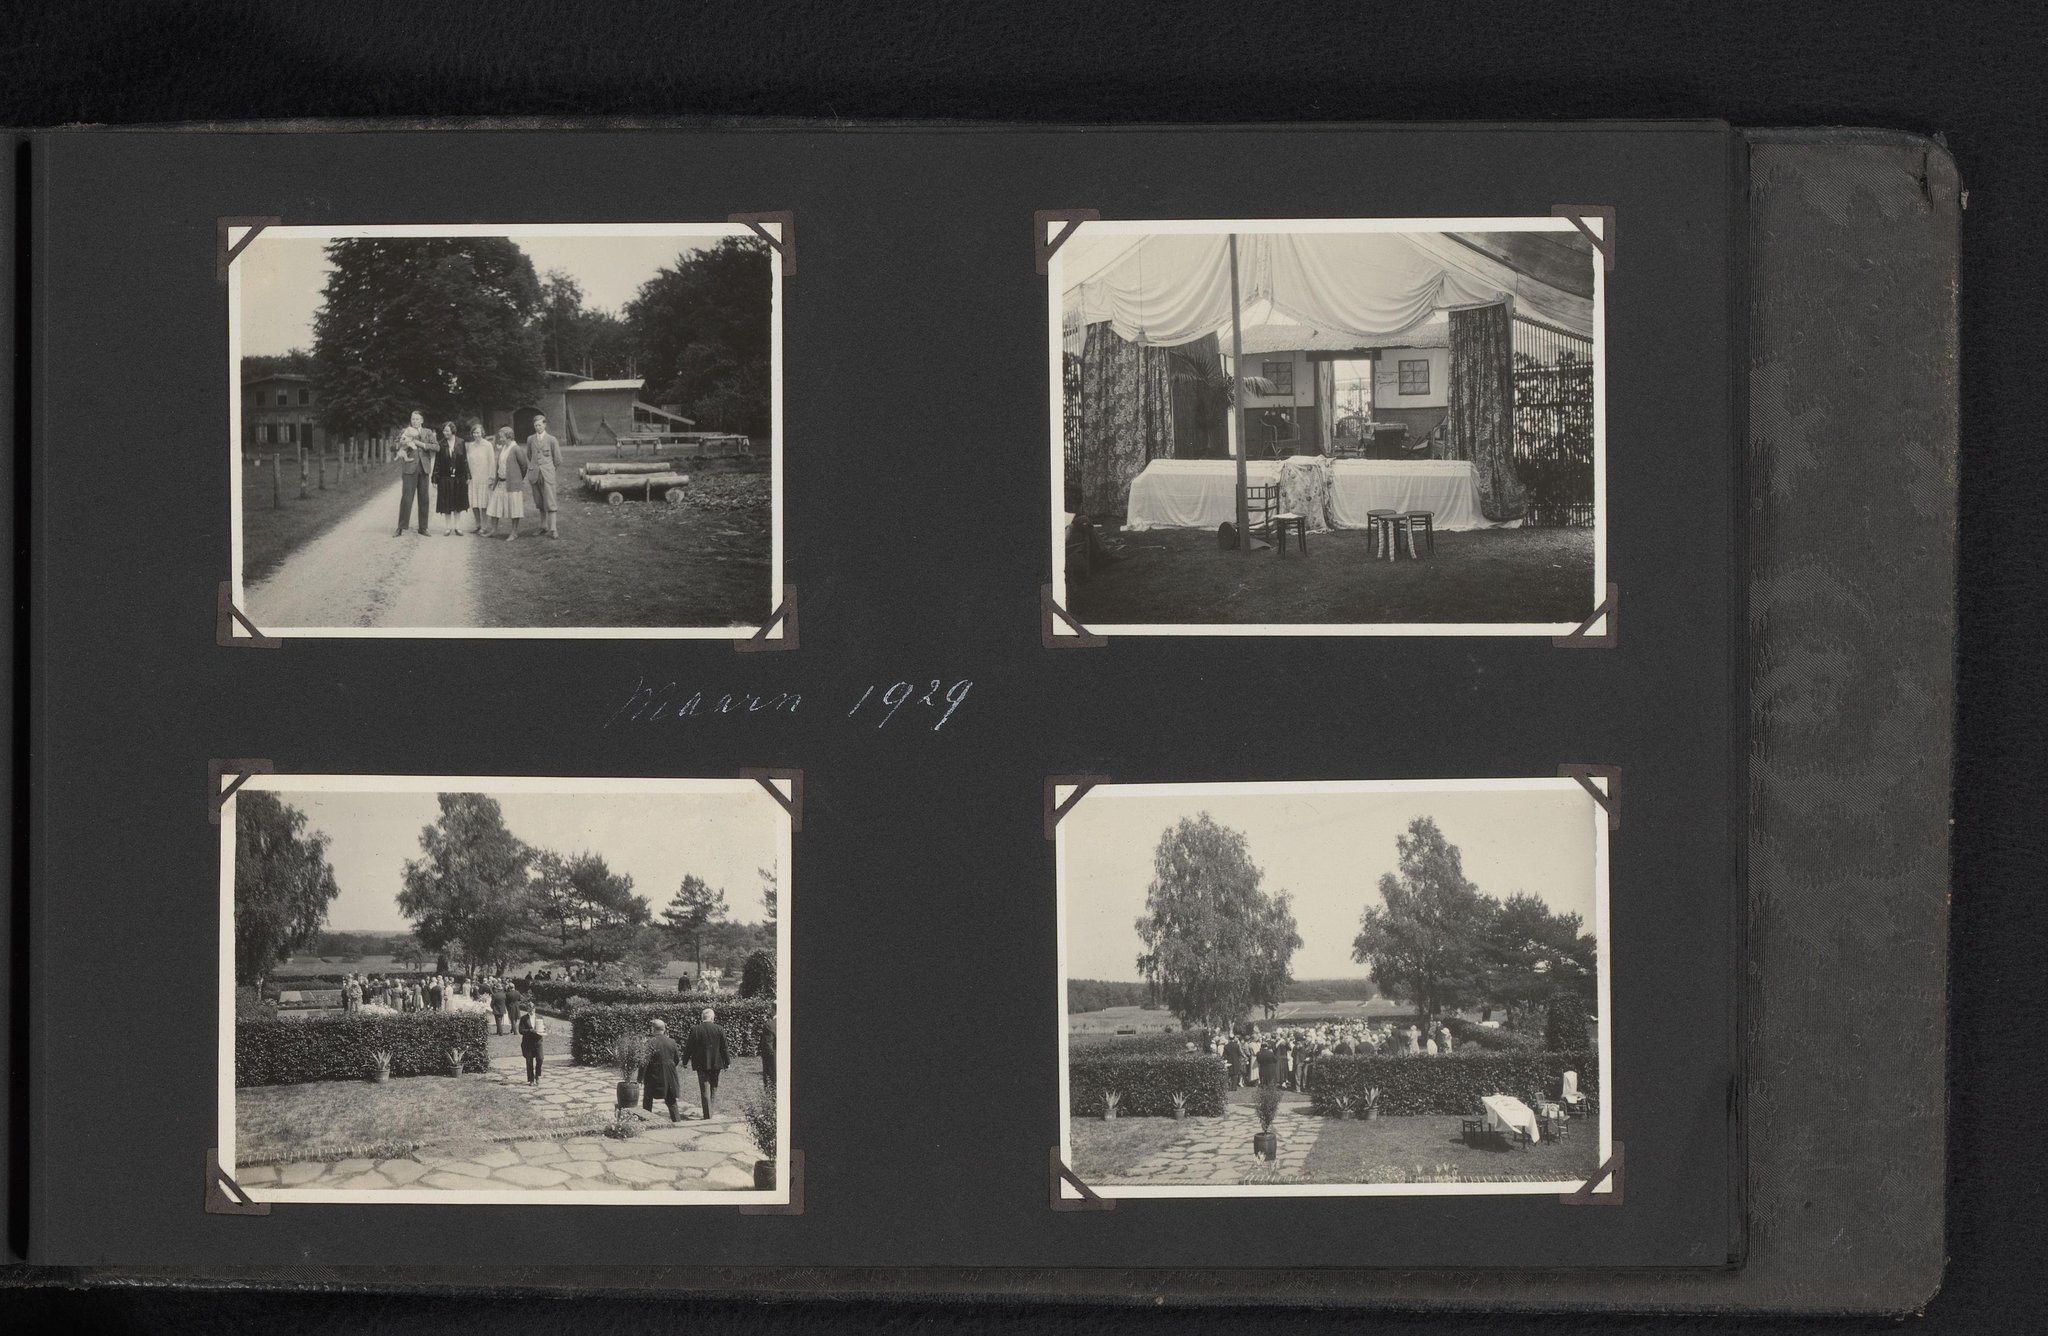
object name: album leaf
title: Vier foto's van een tuinfeest bij landhuis De Hooght, Maarn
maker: hendrik herman van den berg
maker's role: amateurfotograaf, jurist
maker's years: 1875-1944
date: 1929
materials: paper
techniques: gelatin silver print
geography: maarn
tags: garden, country-house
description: Deze foto's maken deel uit van een album.